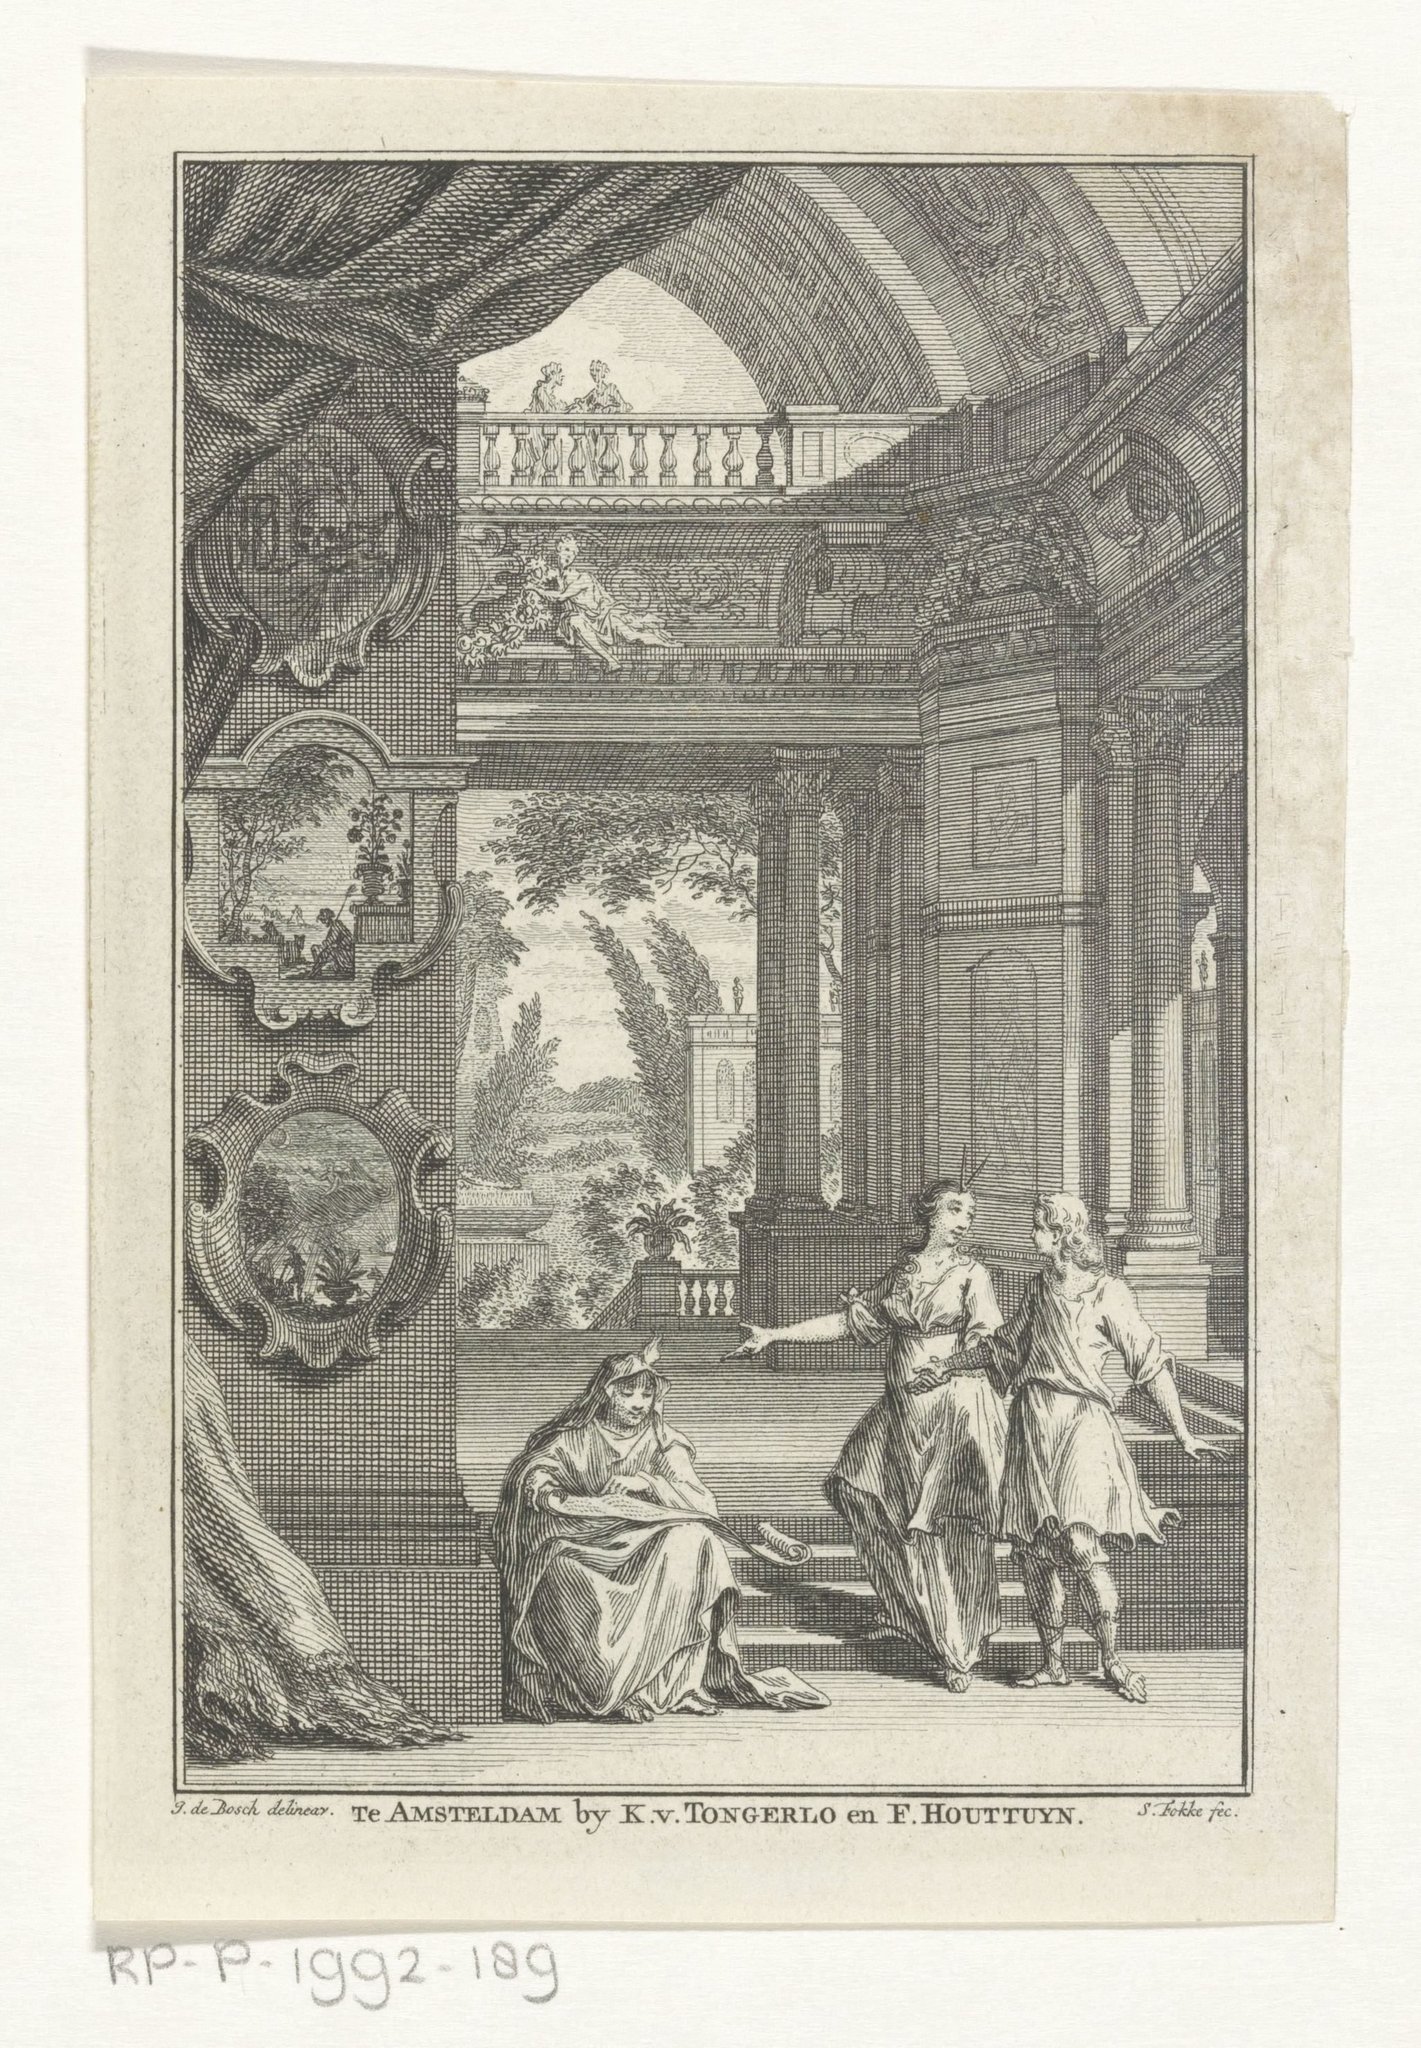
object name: titelblad, titelpagina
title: Allegorische voorstelling met Vroomheid of Geloofsijver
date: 1754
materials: paper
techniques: engraving, etching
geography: amsterdam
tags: faith, 'fides'; 'fede', 'fede catholica', 'fede christiana', 'fede christiana catholica' (ripa) ~ one of the three theological virtues, piety, 'pietas', 'timor dei' ~ the three theological virtues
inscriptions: collector's mark: Lugt 2228, collector's mark: Lugt 2760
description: Een vrouw met passer op het hoofd neemt een figuur bij de hand en toont haar een allegorische figuur met vlam op het hoofd (mogelijk Vroomheid of Geloofsijver). In de achtergrond een interieur met balkon en doorkijk richting een tuin.